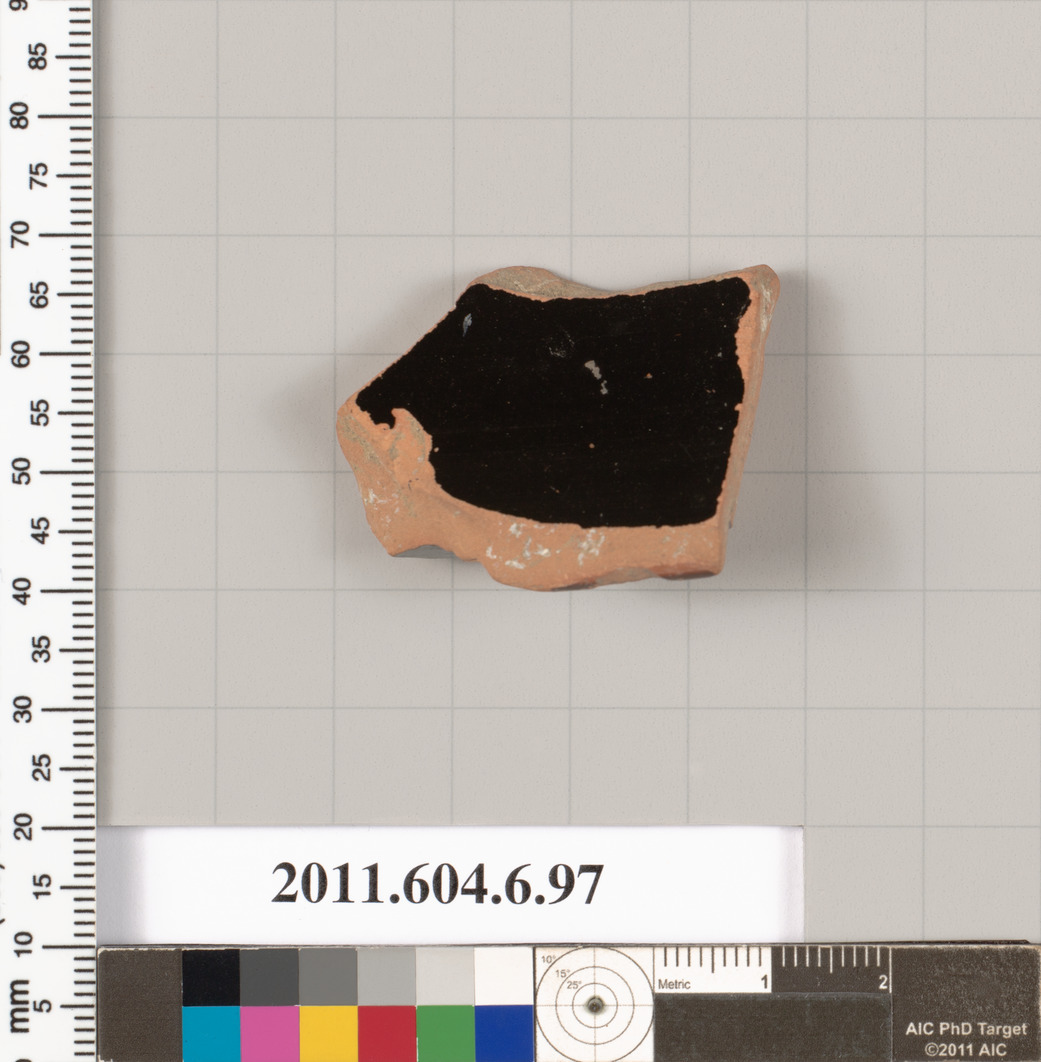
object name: skyphos fragment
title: Terracotta fragment of a skyphos (deep drinking cup)?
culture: greek, attic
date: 500-401 BCE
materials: terracotta